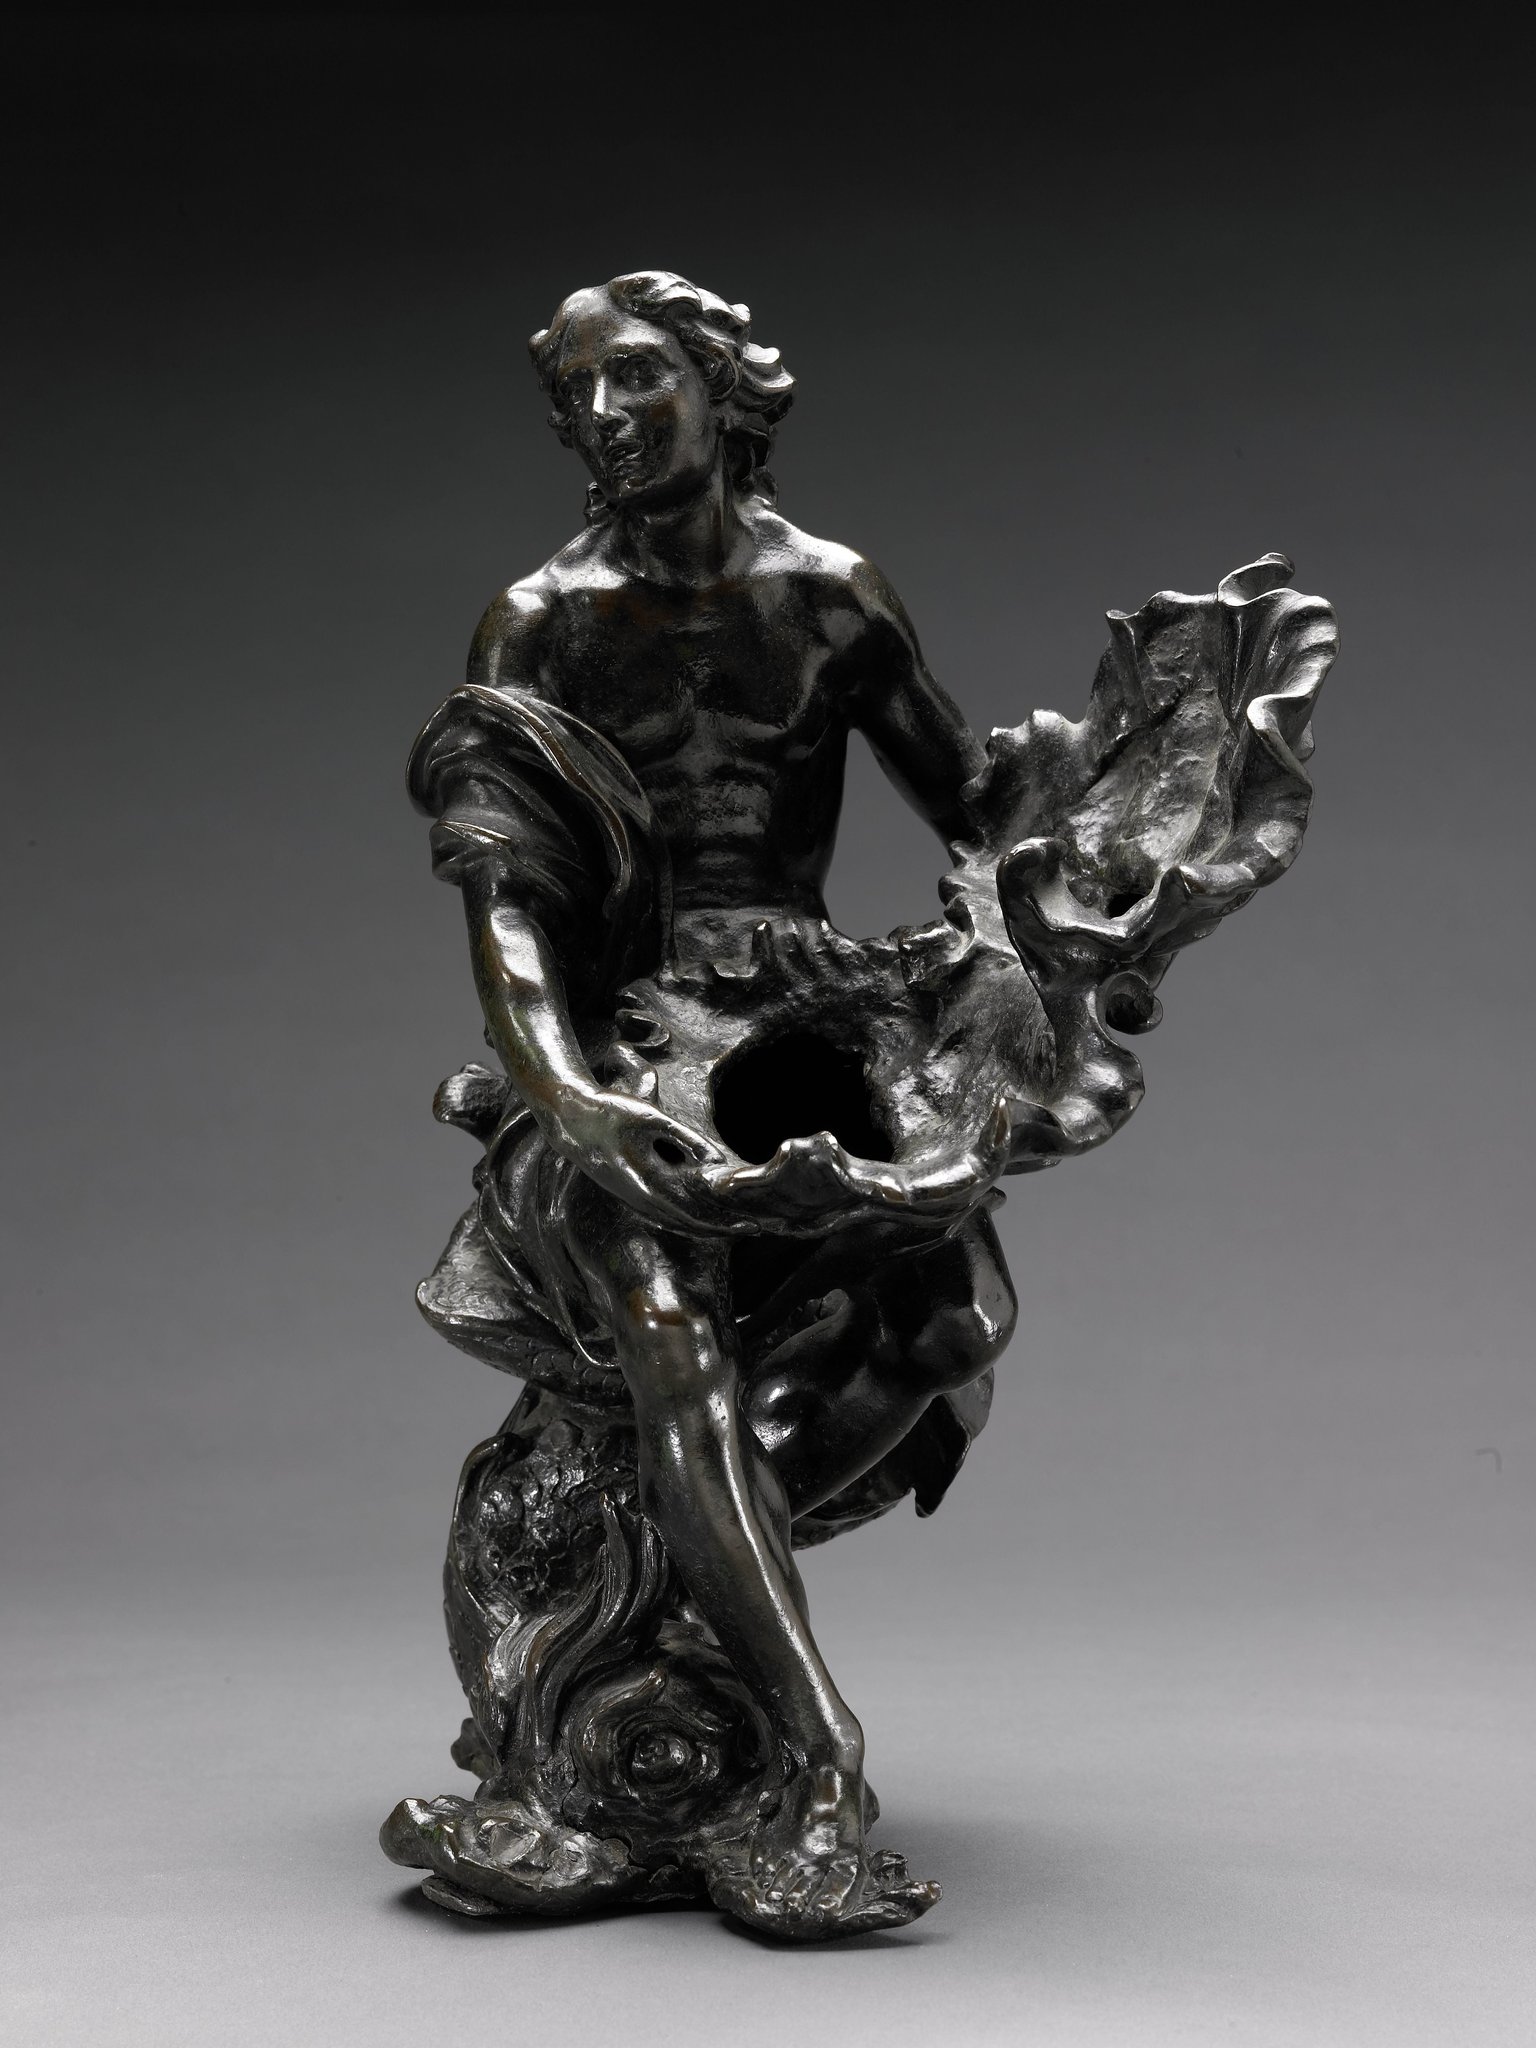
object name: sculpture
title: Inkwell or Salt-Cellar with Arion on the Dolphin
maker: gabriel grupello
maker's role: sculptor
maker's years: 1644-1730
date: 1680-1690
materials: bronze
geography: southern netherlands